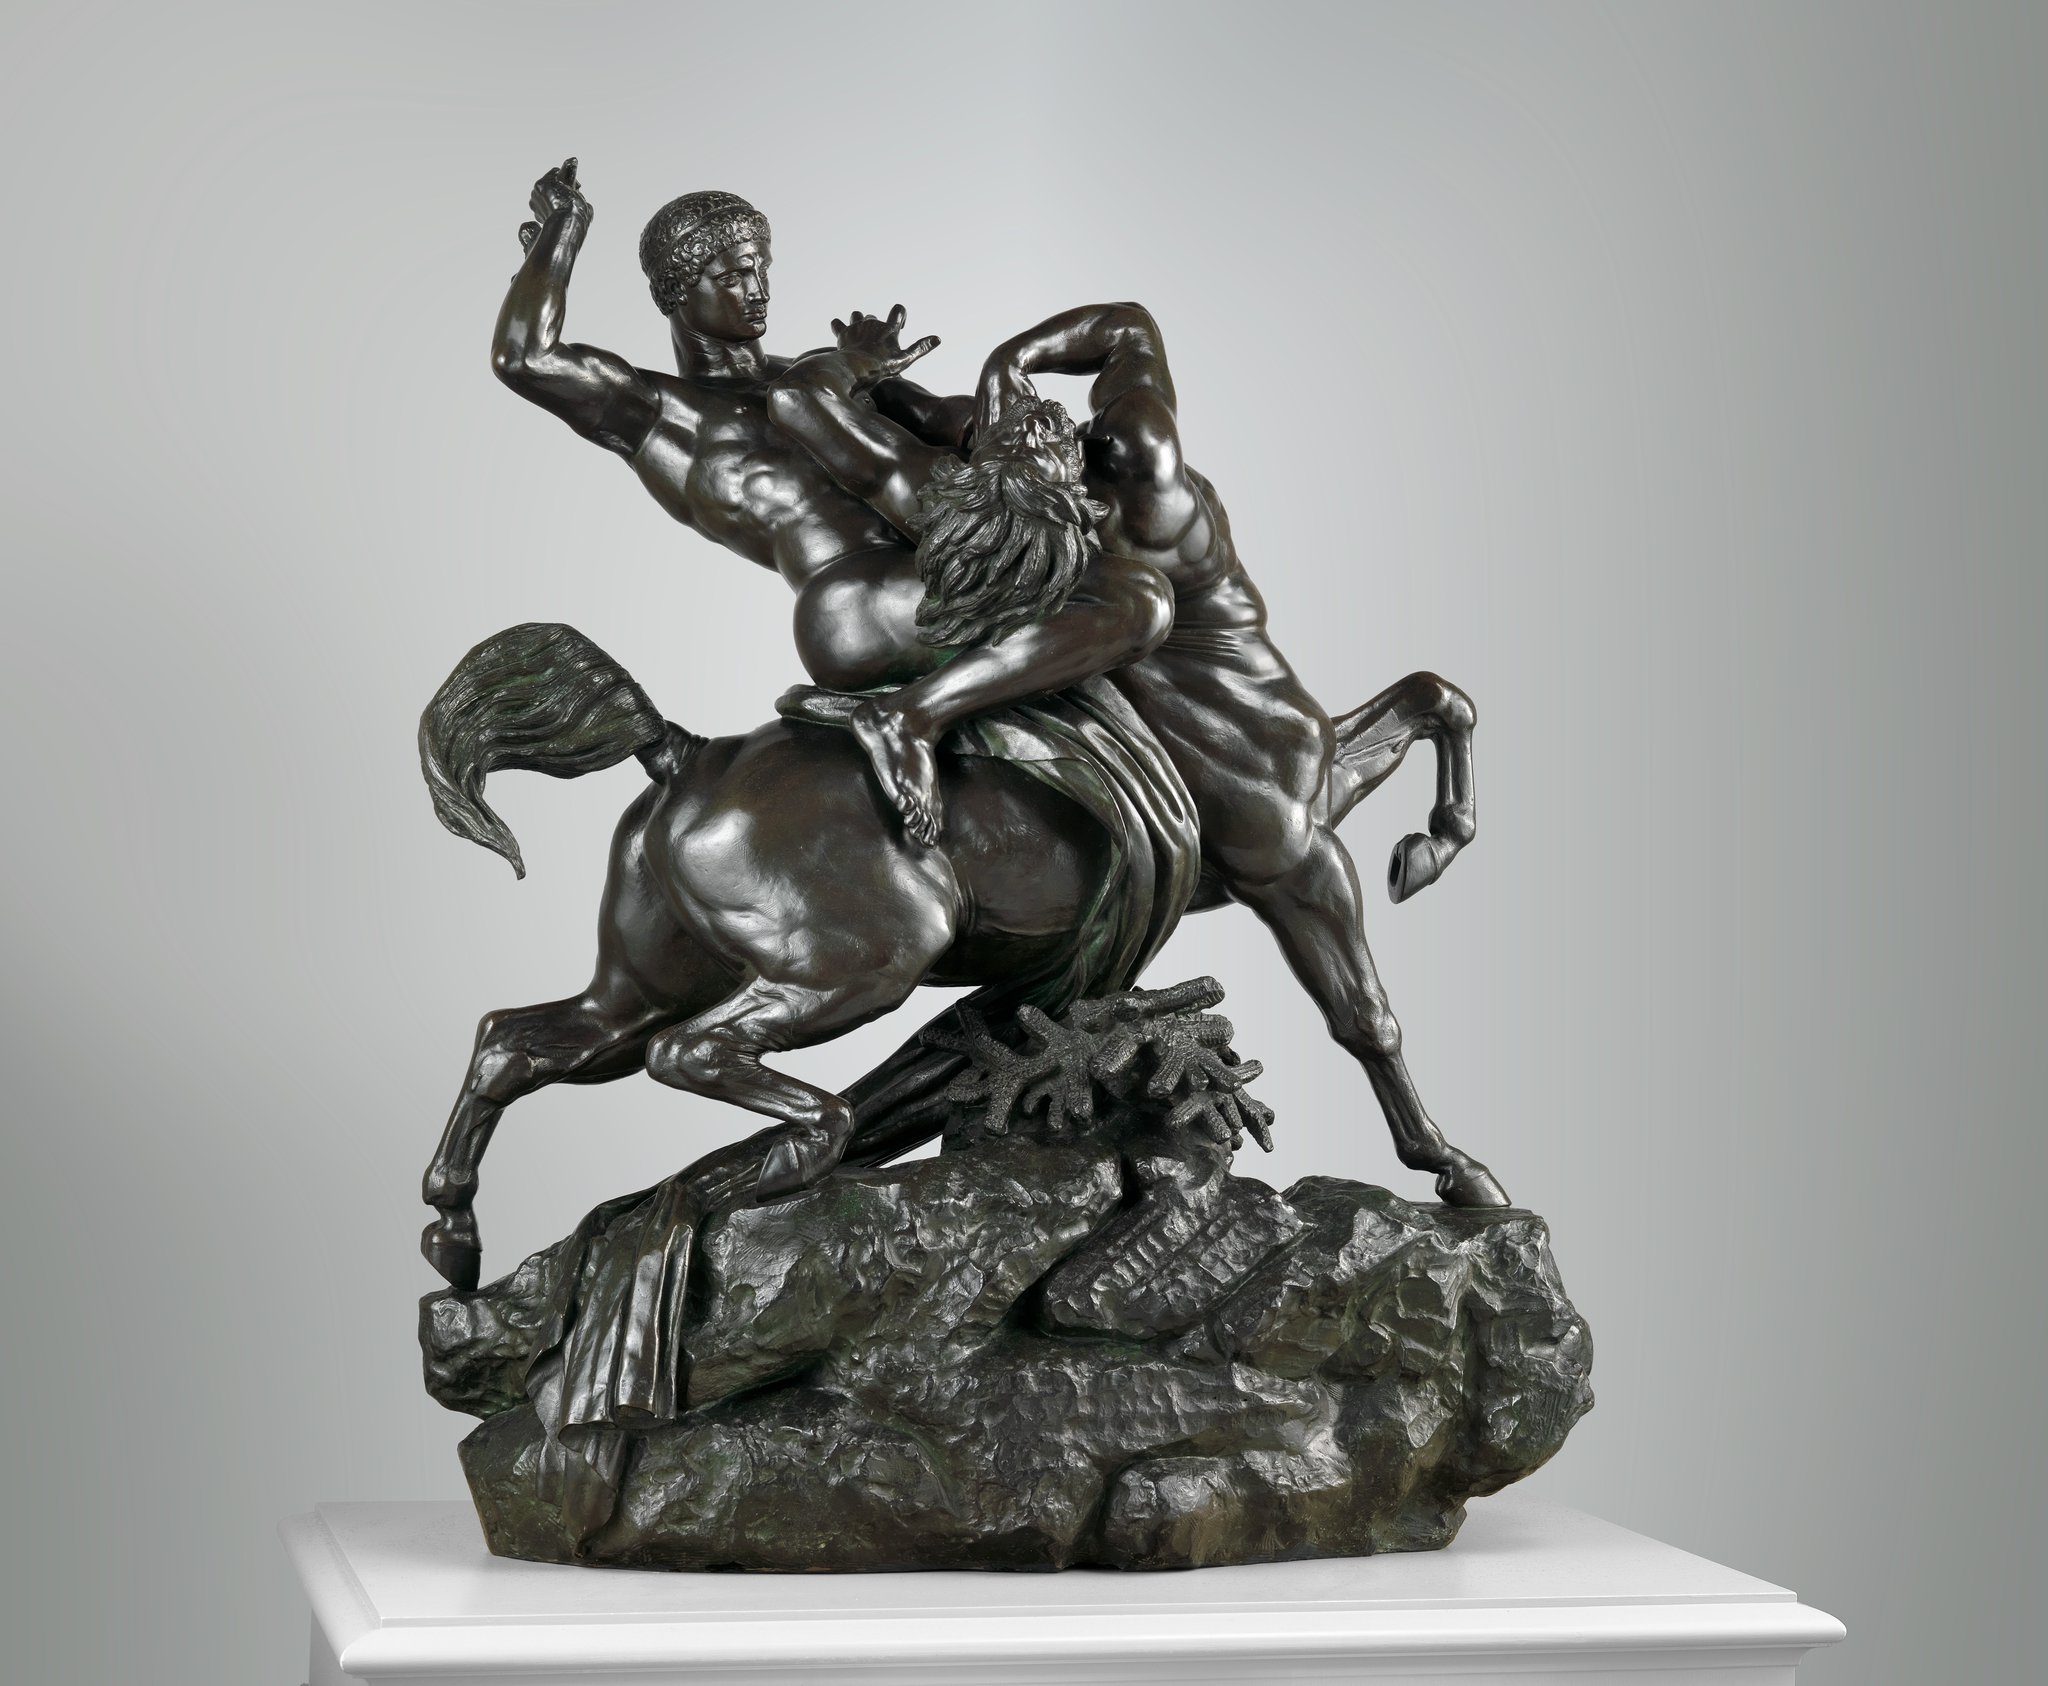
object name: statuette group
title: Theseus Fighting the Centaur Bianor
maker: antoine-louis barye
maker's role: artist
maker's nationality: french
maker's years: 1795-1875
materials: bronze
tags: battles,theseus,centaurs